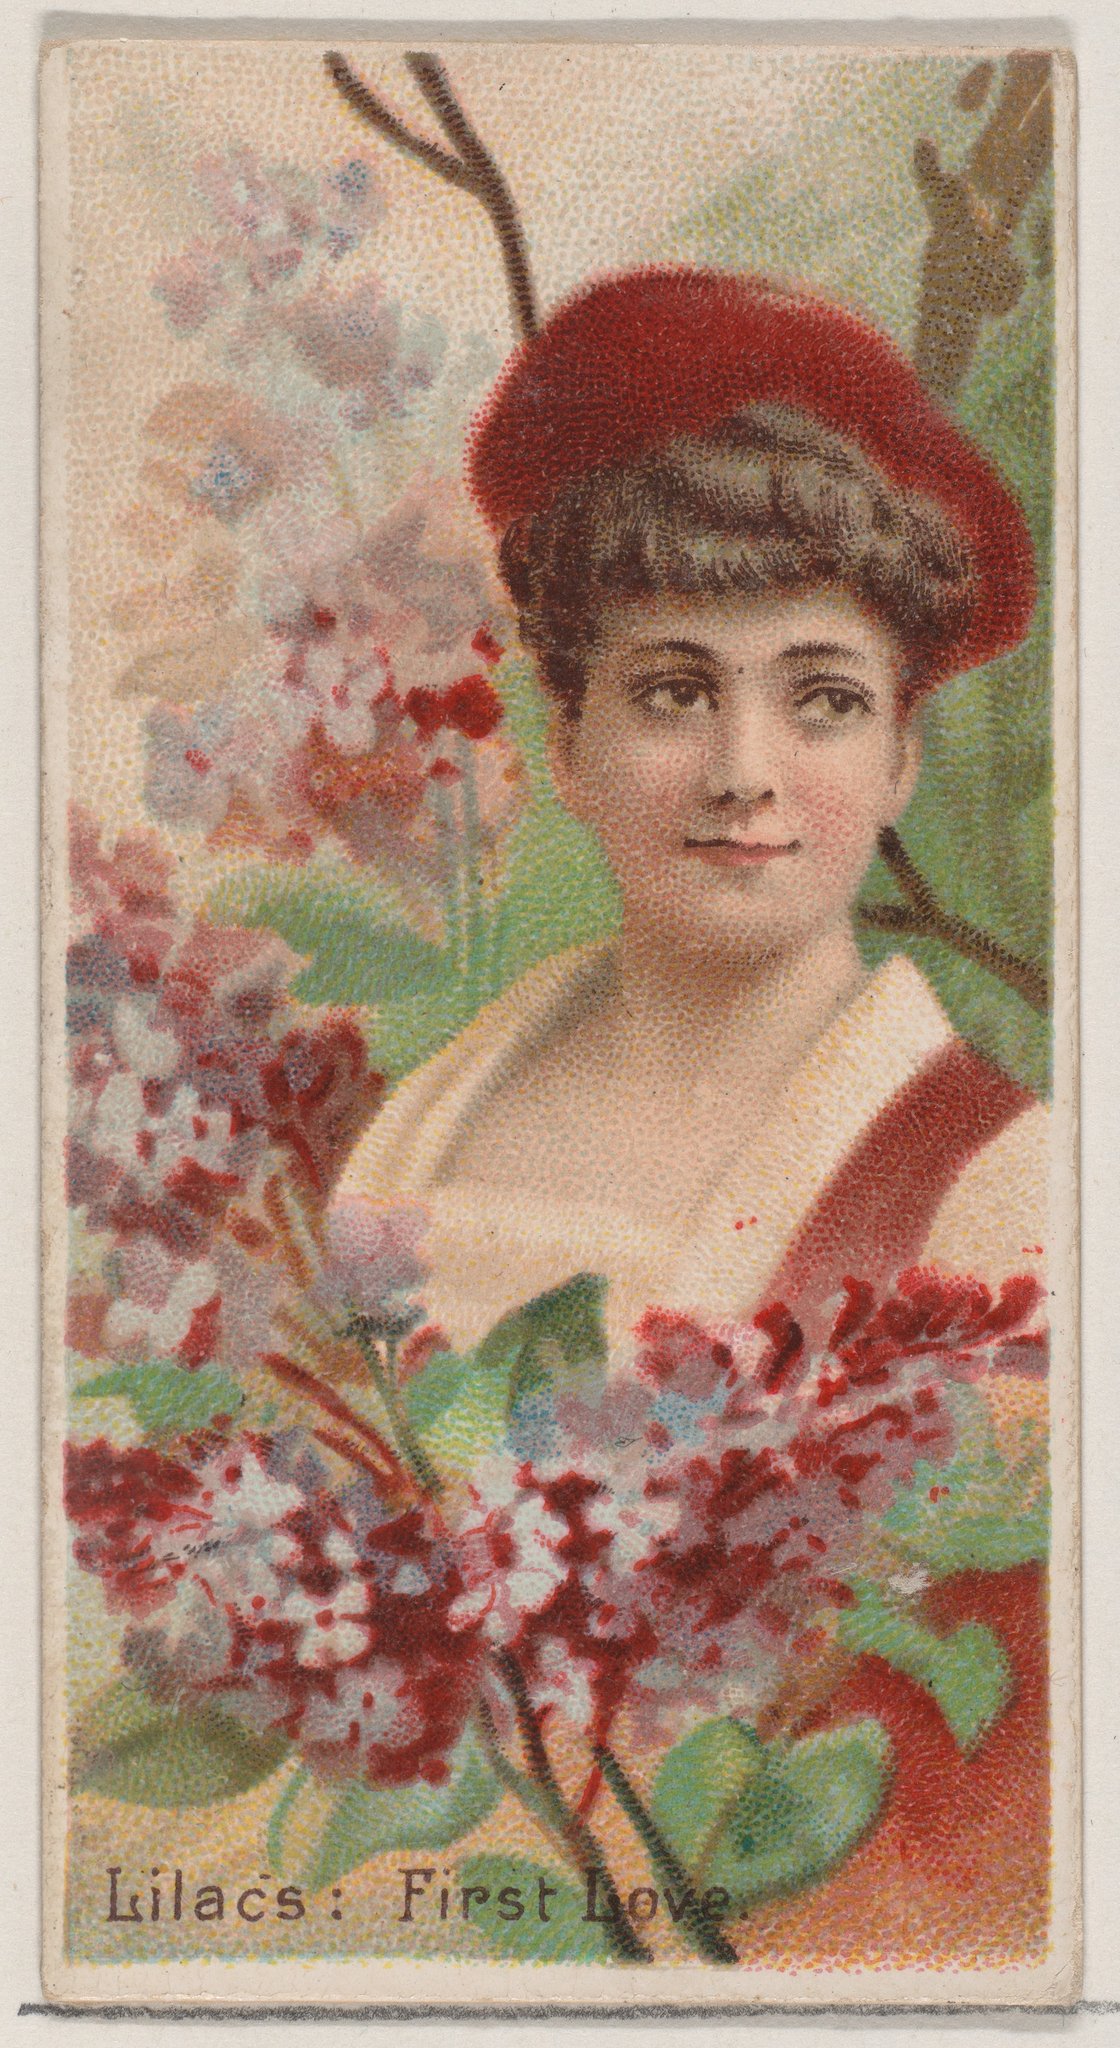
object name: print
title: Lilacs: First Love, from the series Floral Beauties and Language of Flowers (N75) for Duke brand cigarettes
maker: american tobacco company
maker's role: publisher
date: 1892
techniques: color lithograph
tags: women,flowers